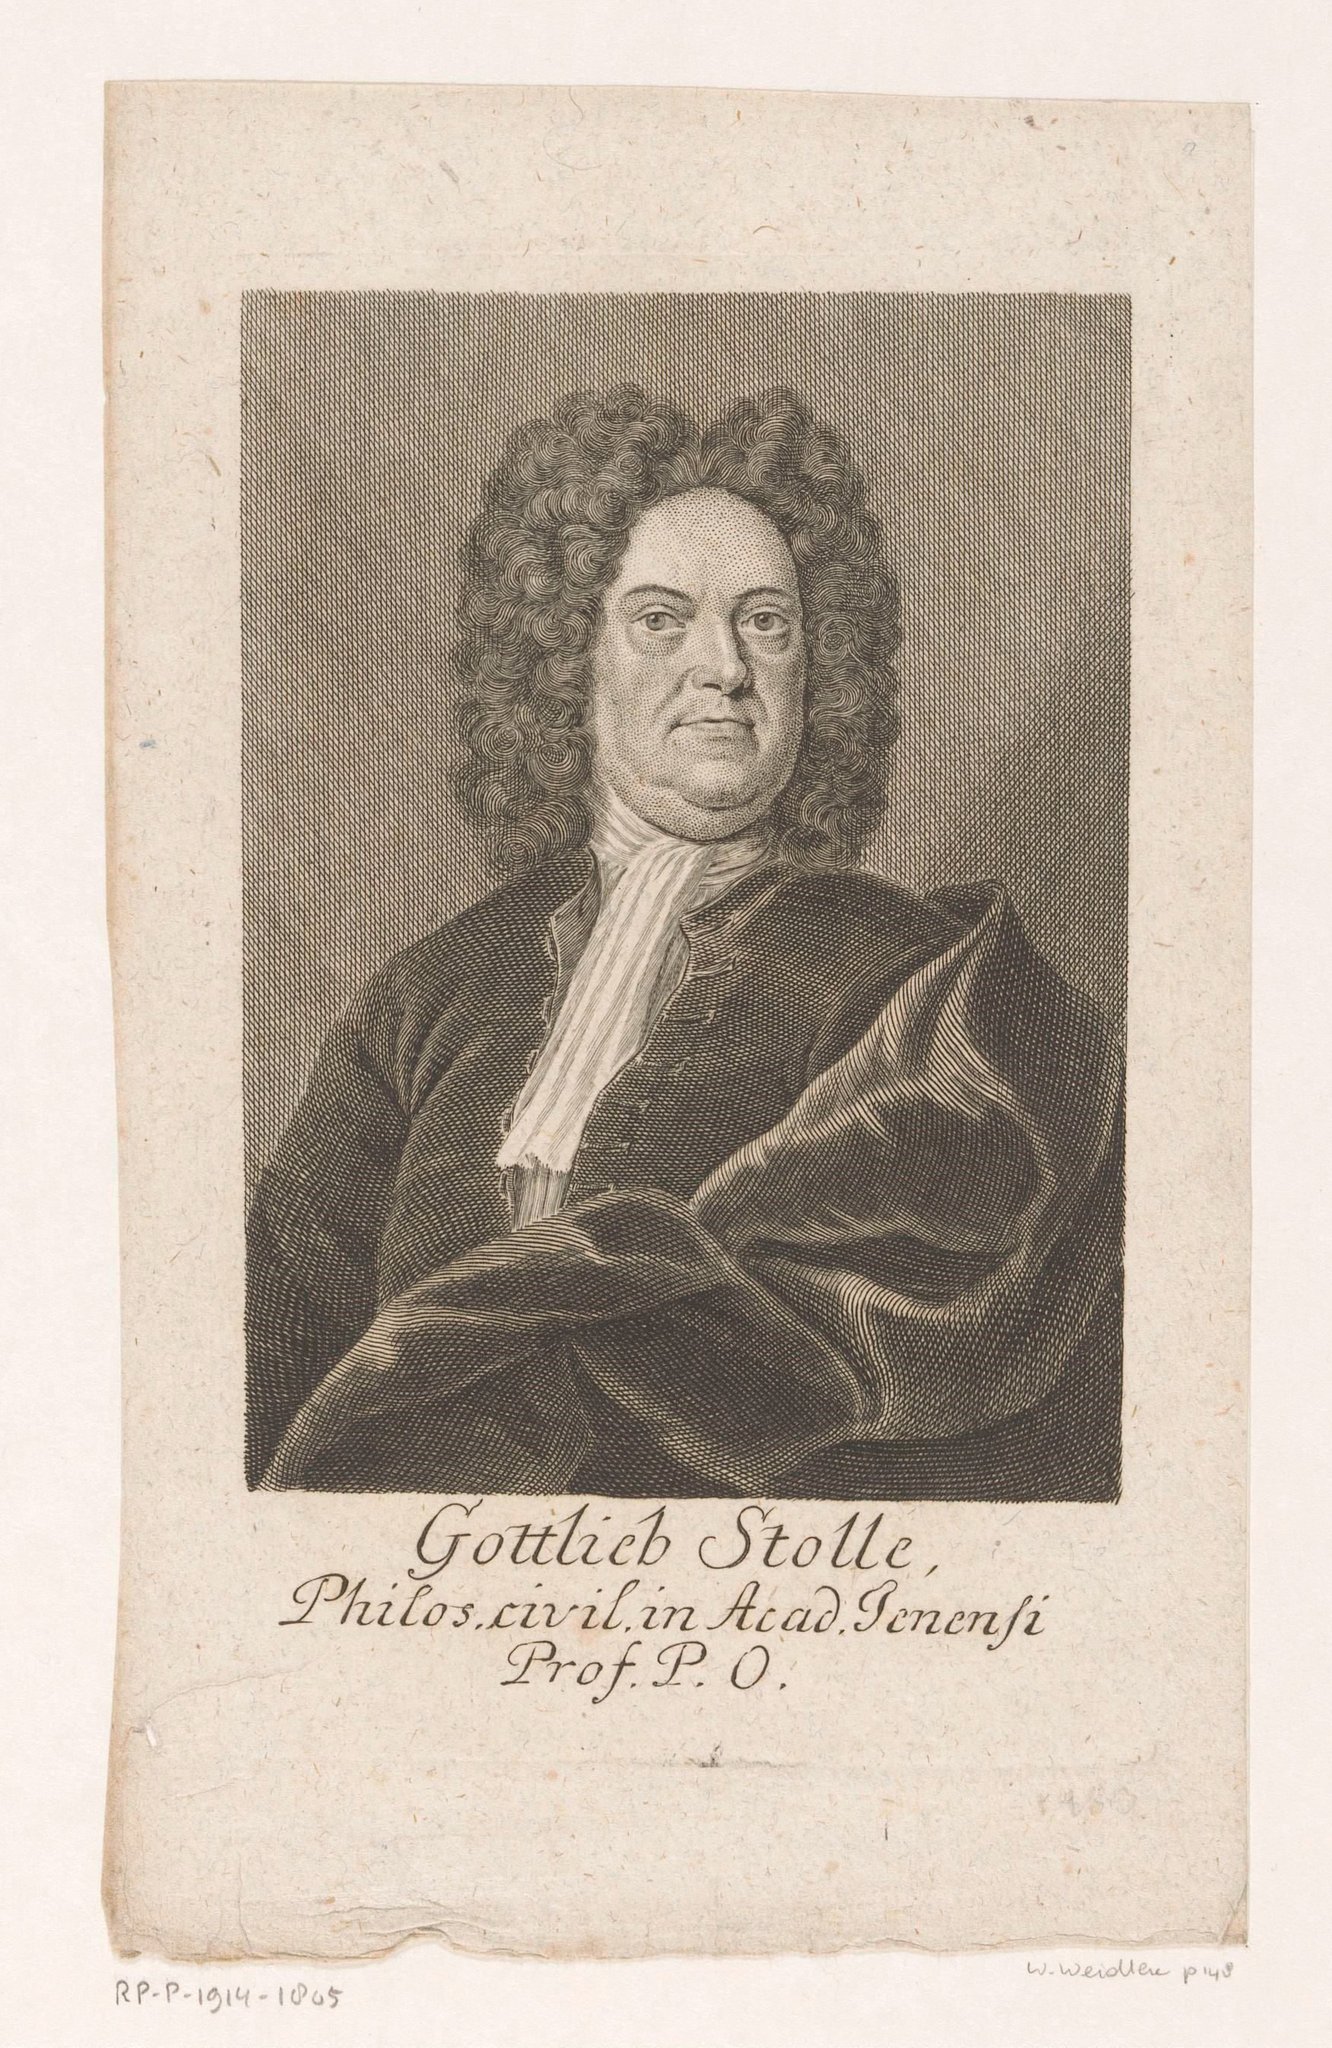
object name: print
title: Portret van Gottlieb Stolle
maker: martin bernigeroth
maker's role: print maker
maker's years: 1670-1733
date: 1728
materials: paper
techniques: engraving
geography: leipzig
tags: historical persons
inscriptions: collector's mark: Lugt 2228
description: Prent ook gebruikt in: Deutsche Acta Eruditorum (...). dl. 138. Leipzig: Johann Gottlieb Gleditsch, 1728.